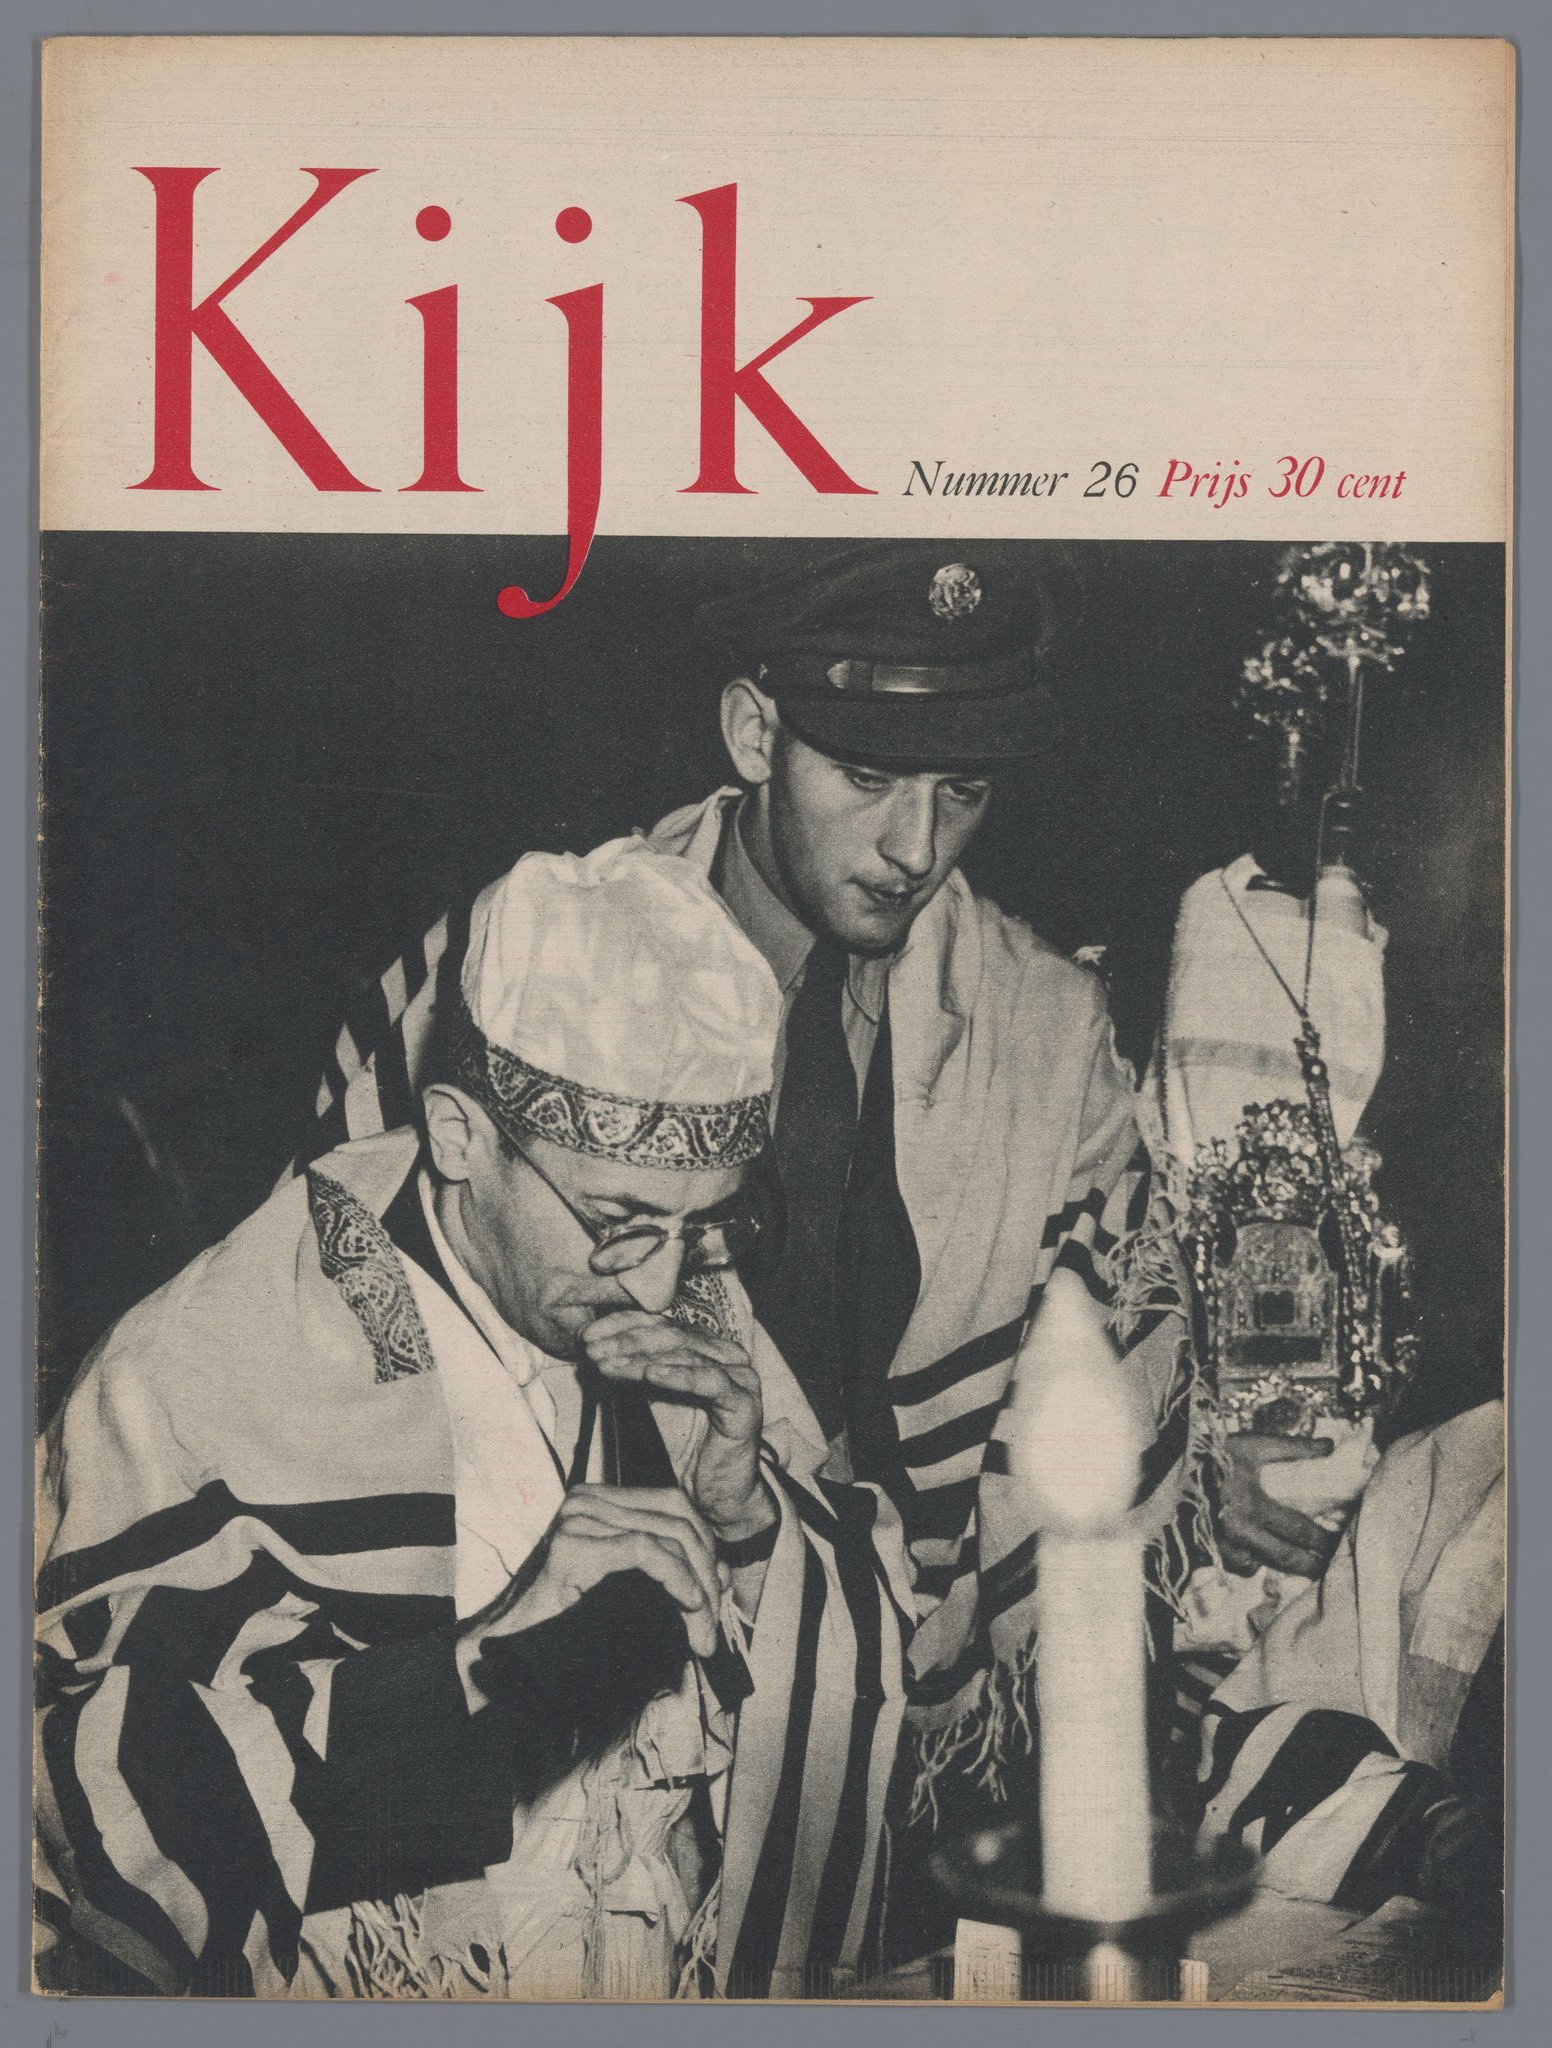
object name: magazine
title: 'Kijk', exemplaar nr. 26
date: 1945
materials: paper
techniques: printing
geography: london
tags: tweede wereldoorlog, bevrijding van nederland (1945)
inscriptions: title: ‘Kijk’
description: "Kijk wordt om de veertien dagen uitgegeven door de Amerikaanschen Voorlichingsdienst om eht wereldnieuws te geven in woord en beeld, totdat uw eigen pers deze taak kan overnemen." Omschrijving van het blad Kijk, overgenomen uit dit blad.